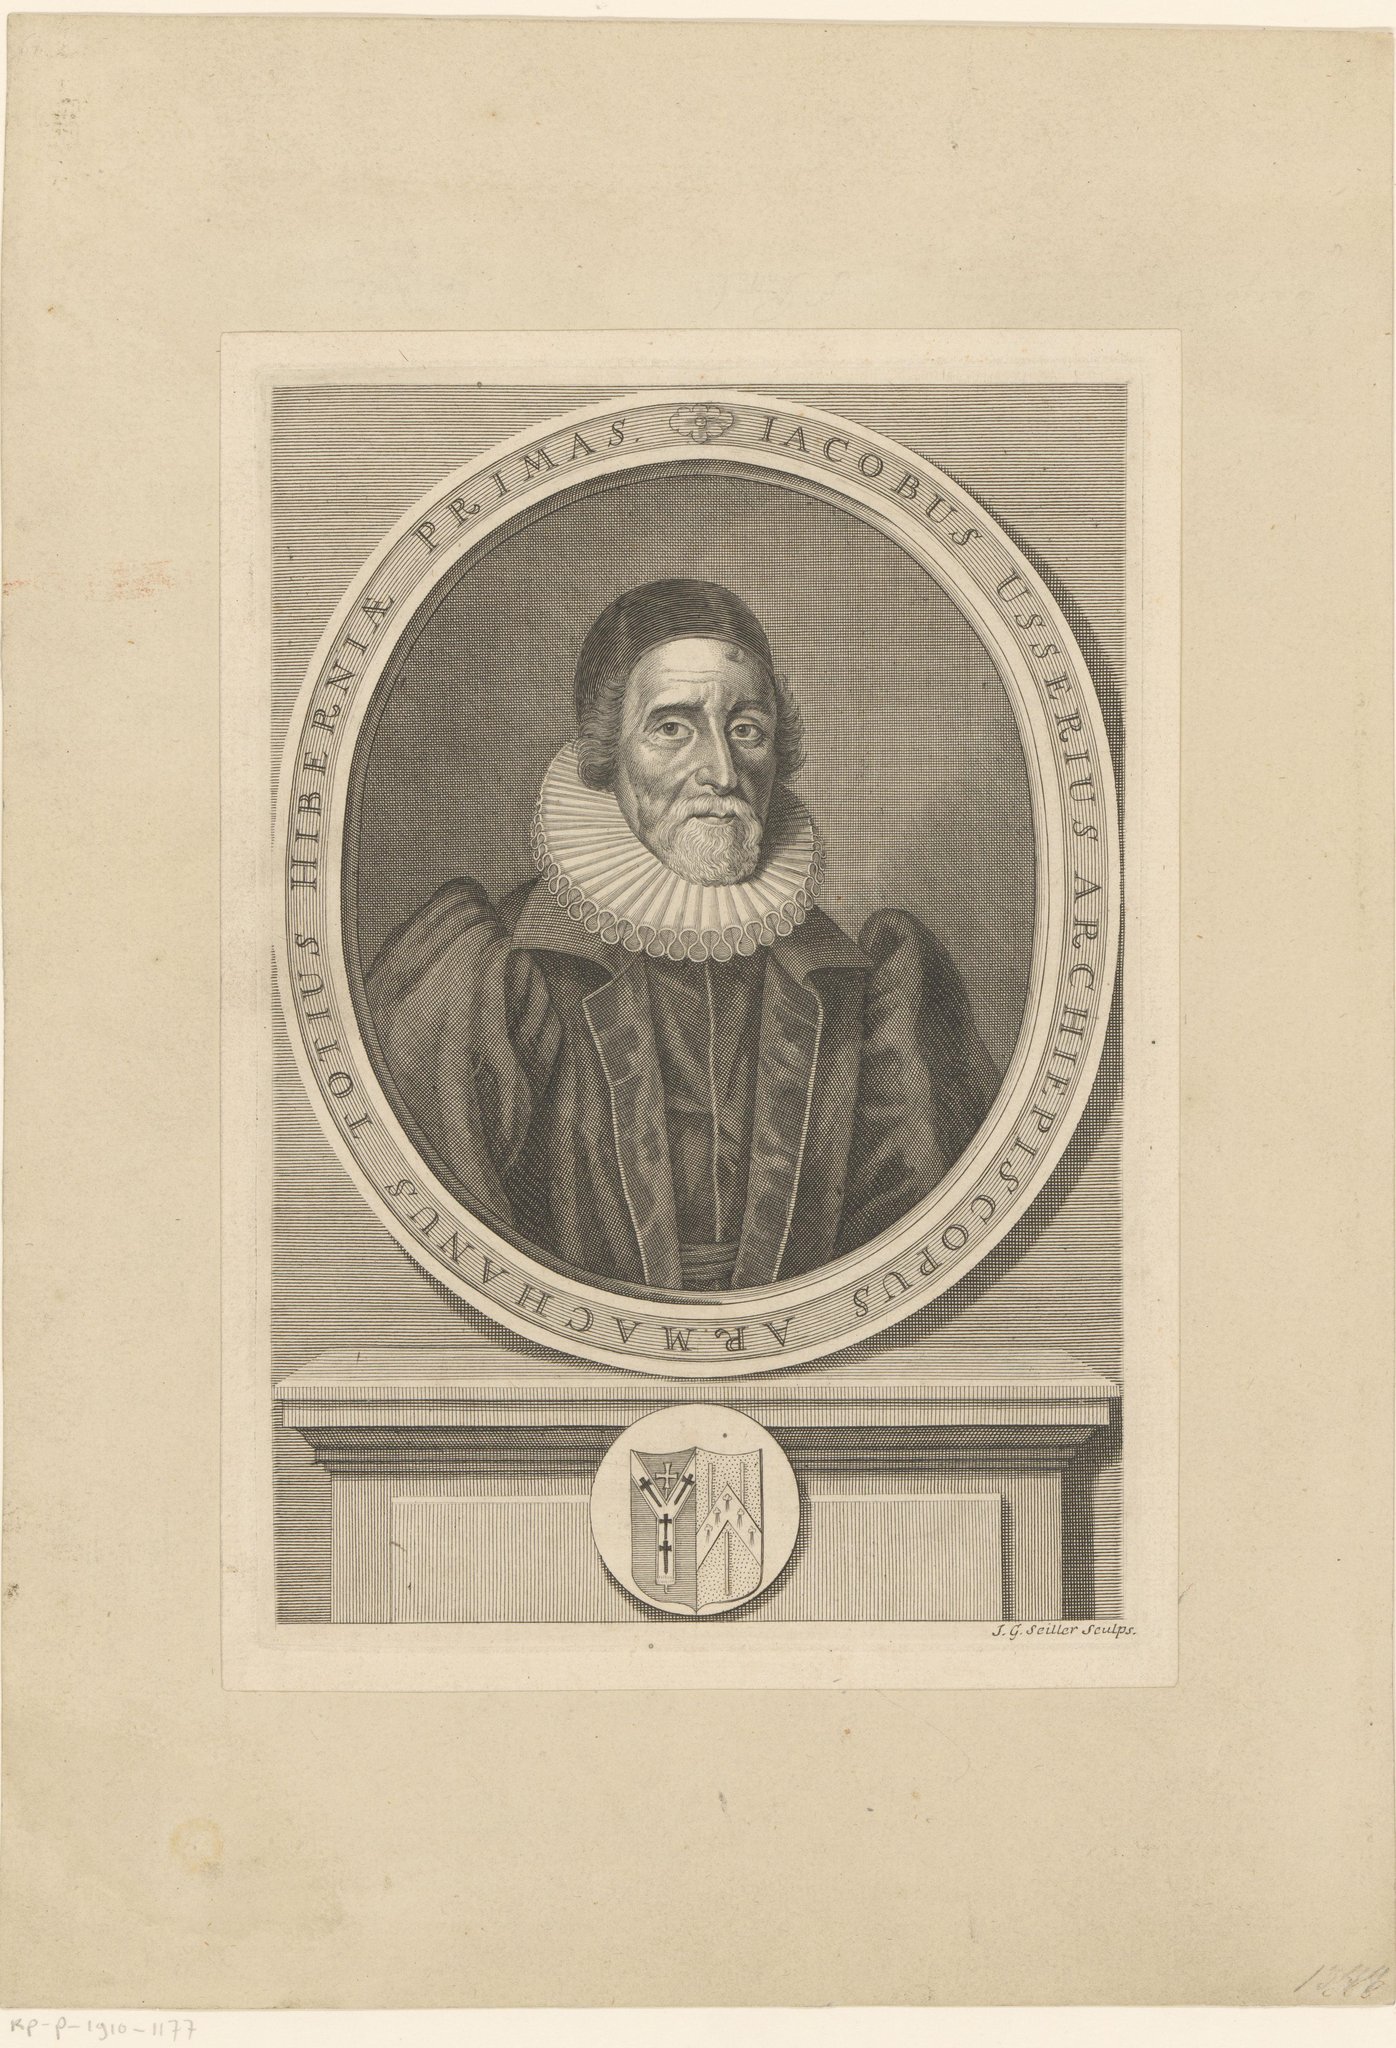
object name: print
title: Portret van James Ussher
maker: johann georg seiller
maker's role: print maker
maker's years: 1663-1740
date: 1673-1740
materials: paper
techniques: engraving, etching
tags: historical persons, armorial bearing, heraldry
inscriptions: collector's mark: Lugt 2228